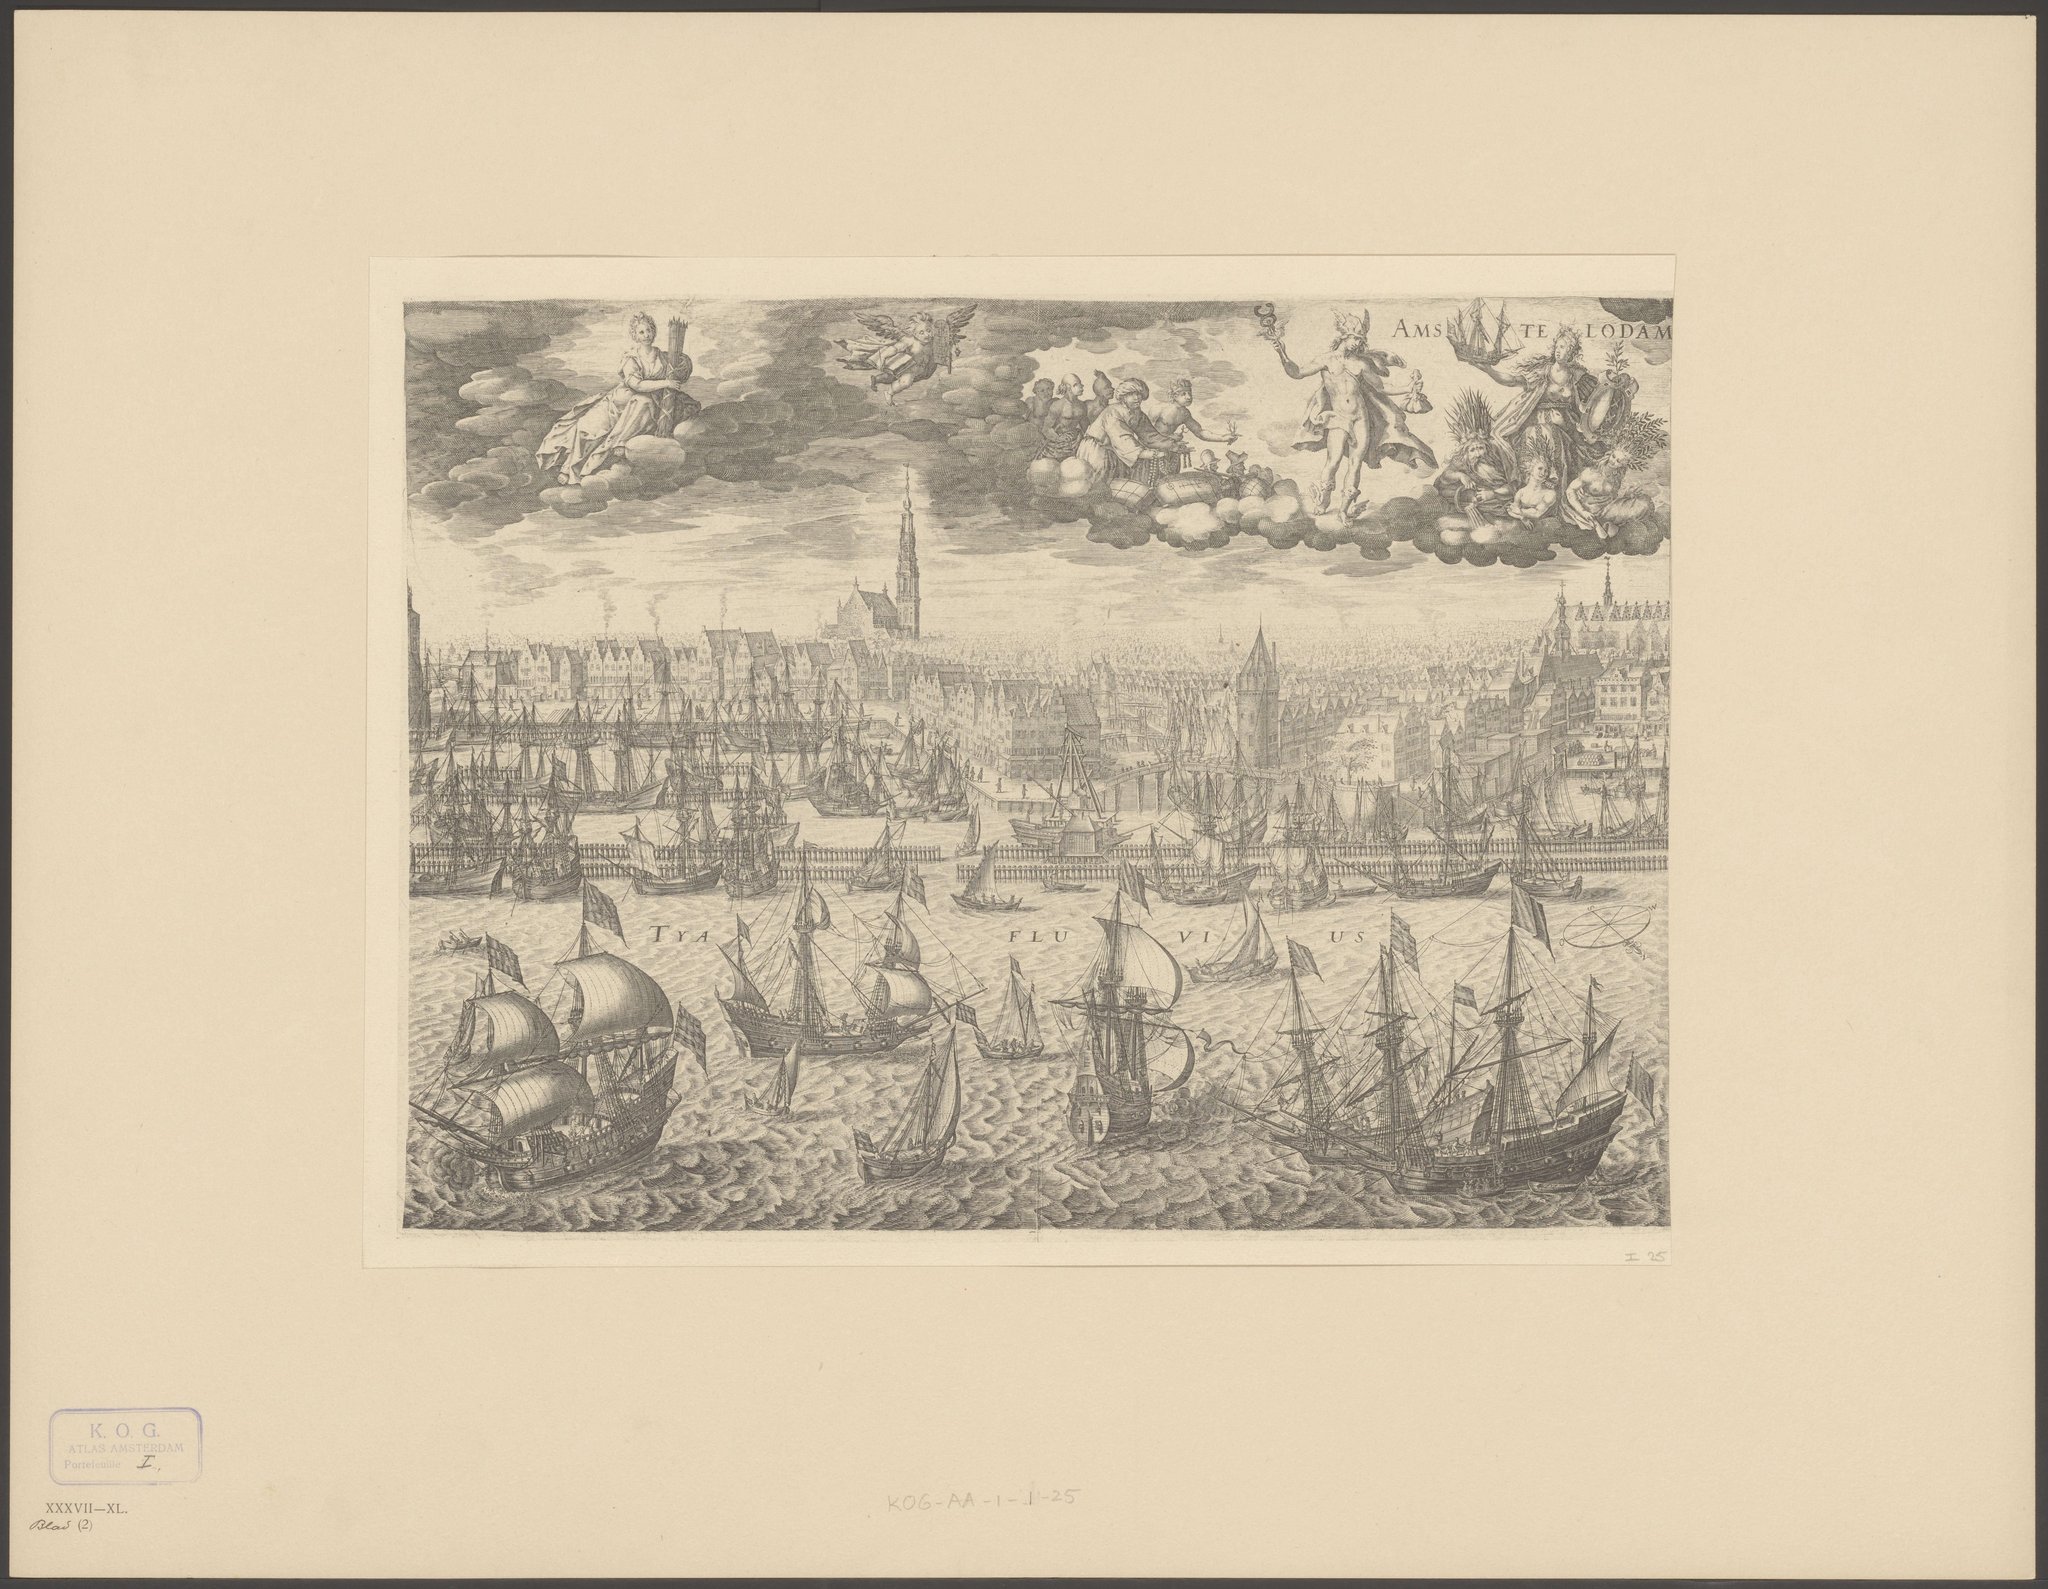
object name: photomechanical print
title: Gezicht op de stad Amsterdam vanaf het IJ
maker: Anonymous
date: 1875-1968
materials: paper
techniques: photograph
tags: city-view in general; 'veduta', river, ships (in general) - cc - more than one ship, amsterdam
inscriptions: inscription: ‘XXXVII-XL. / Blad (2)’, collector's mark: ‘1’ Lugt 1641b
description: Onderwerpsrubriek binnen de Atlas Amsterdam: Gezichten van den geheelen IJkant der Stad.